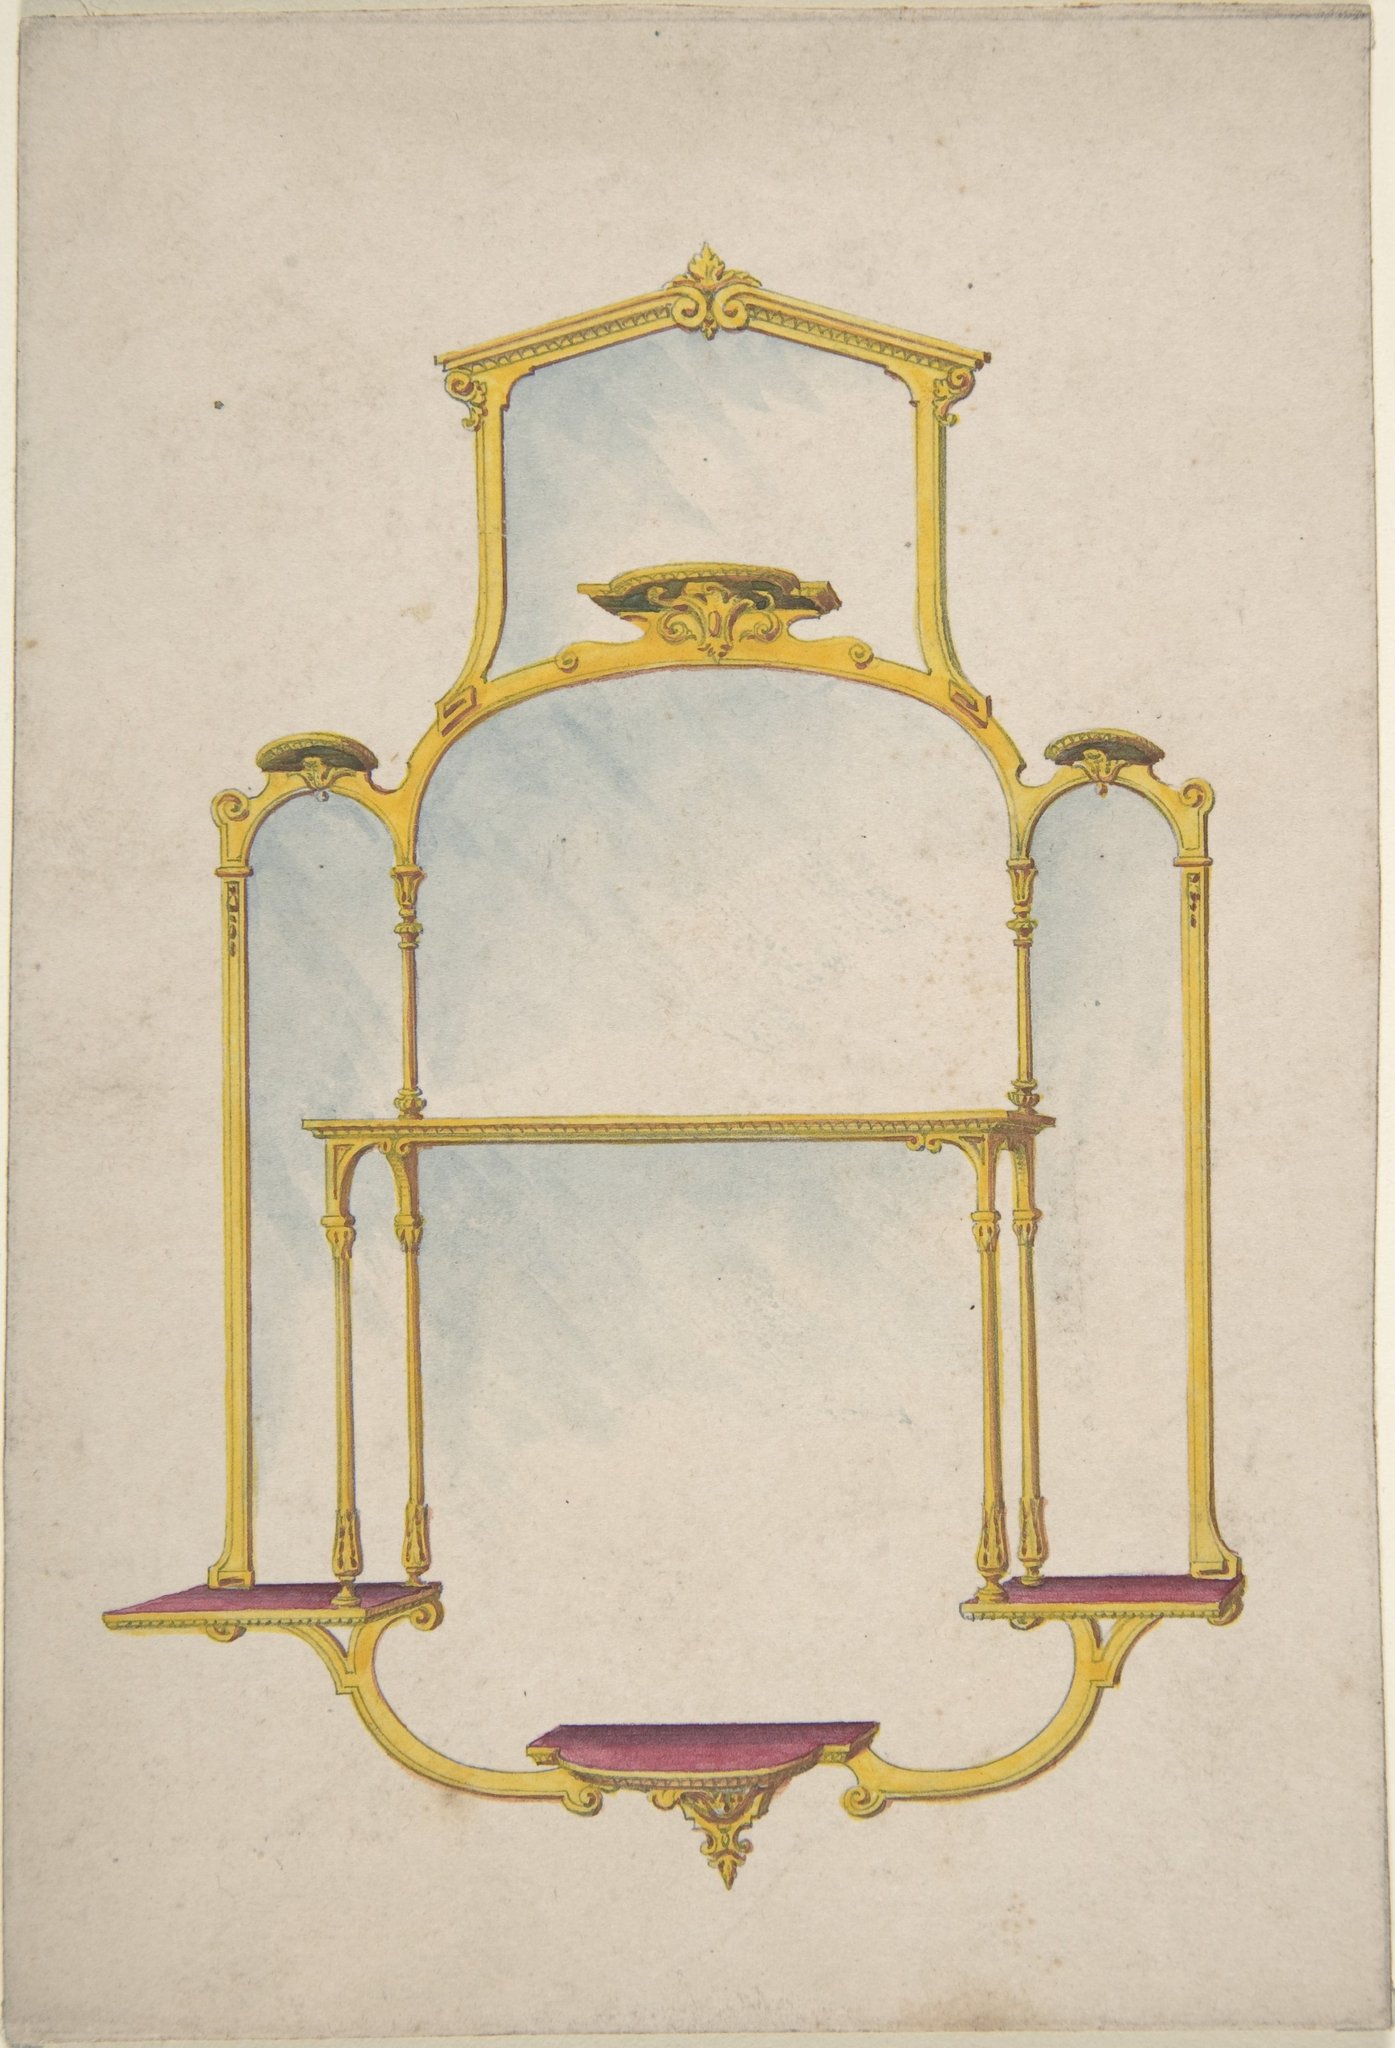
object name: drawing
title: Design for a Hanging Mirror with Shelves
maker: anonymous, british, 19th century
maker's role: artist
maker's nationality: british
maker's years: 1800-1900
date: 1801-1900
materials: ink, watercolor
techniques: pen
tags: mirrors